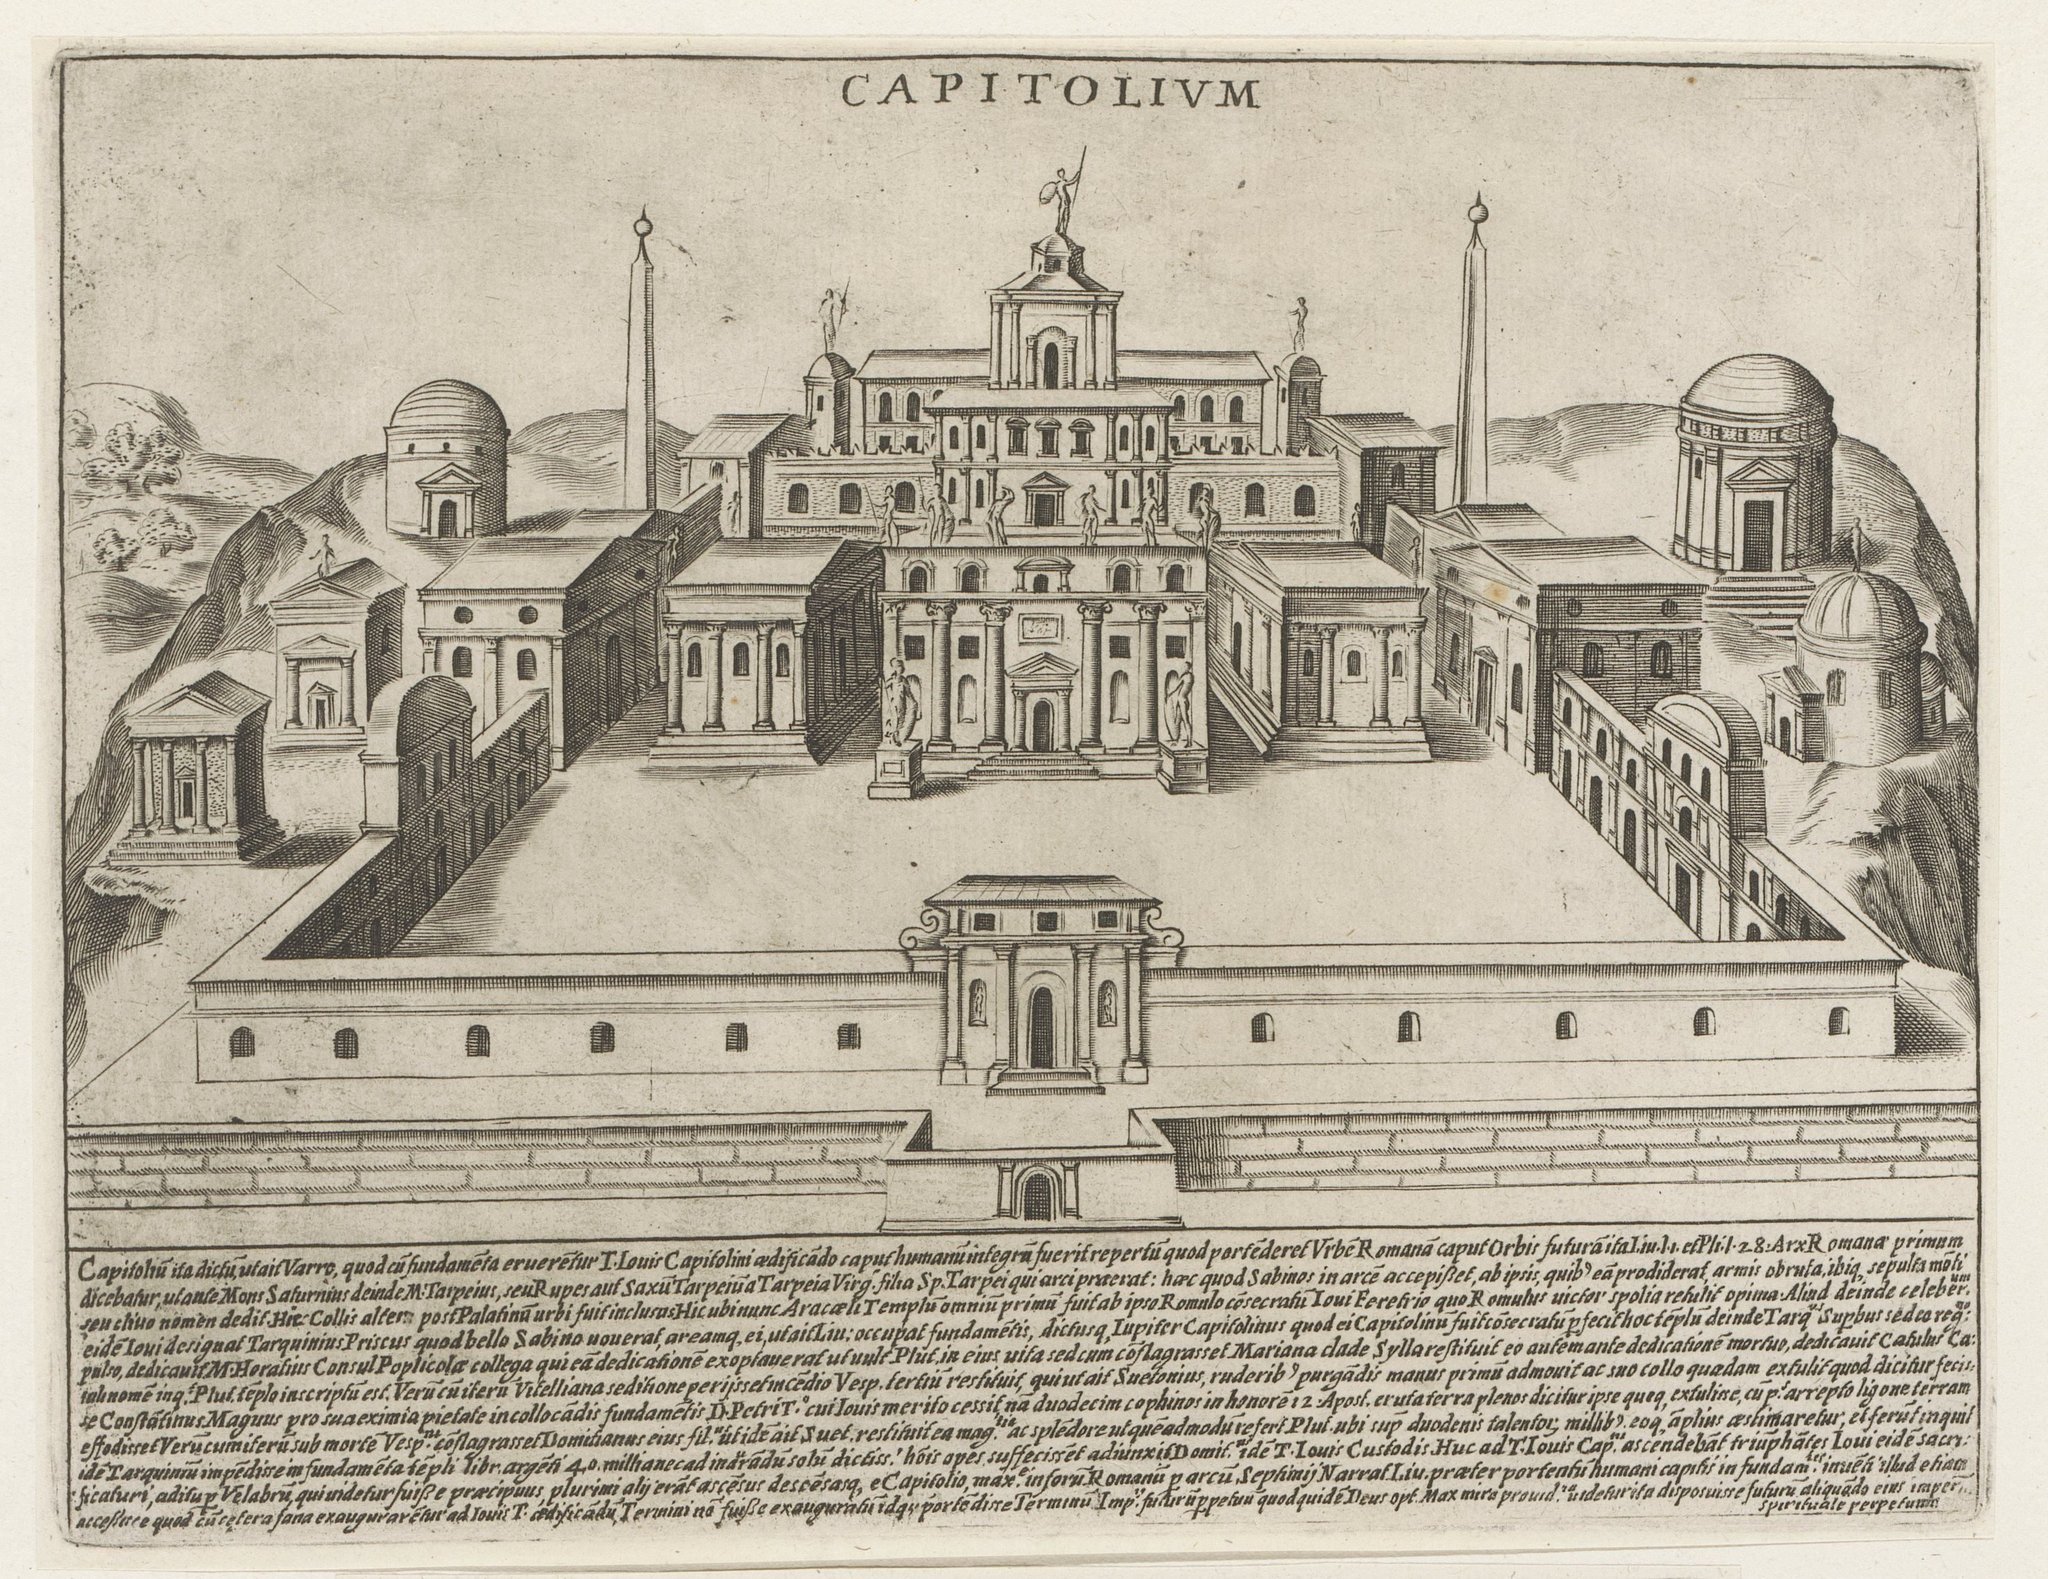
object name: album leaf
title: Antiquae Urbis Splendor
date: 1612-1628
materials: paper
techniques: etching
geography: rome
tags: square, place, circus, etc., representation of real building (either existing or having existed)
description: Deze prent maakt deel uit van een set van 158 prenten (+ titelprenten), die verscheen in vier delen. In 1612 verschenen delen één en twee. In 1615 verscheen het derde deel en in 1628 verscheen deel vier. In 1637 publiceerde Vitale Mascardi de eerste heruitgave van de gehele set met nummering.